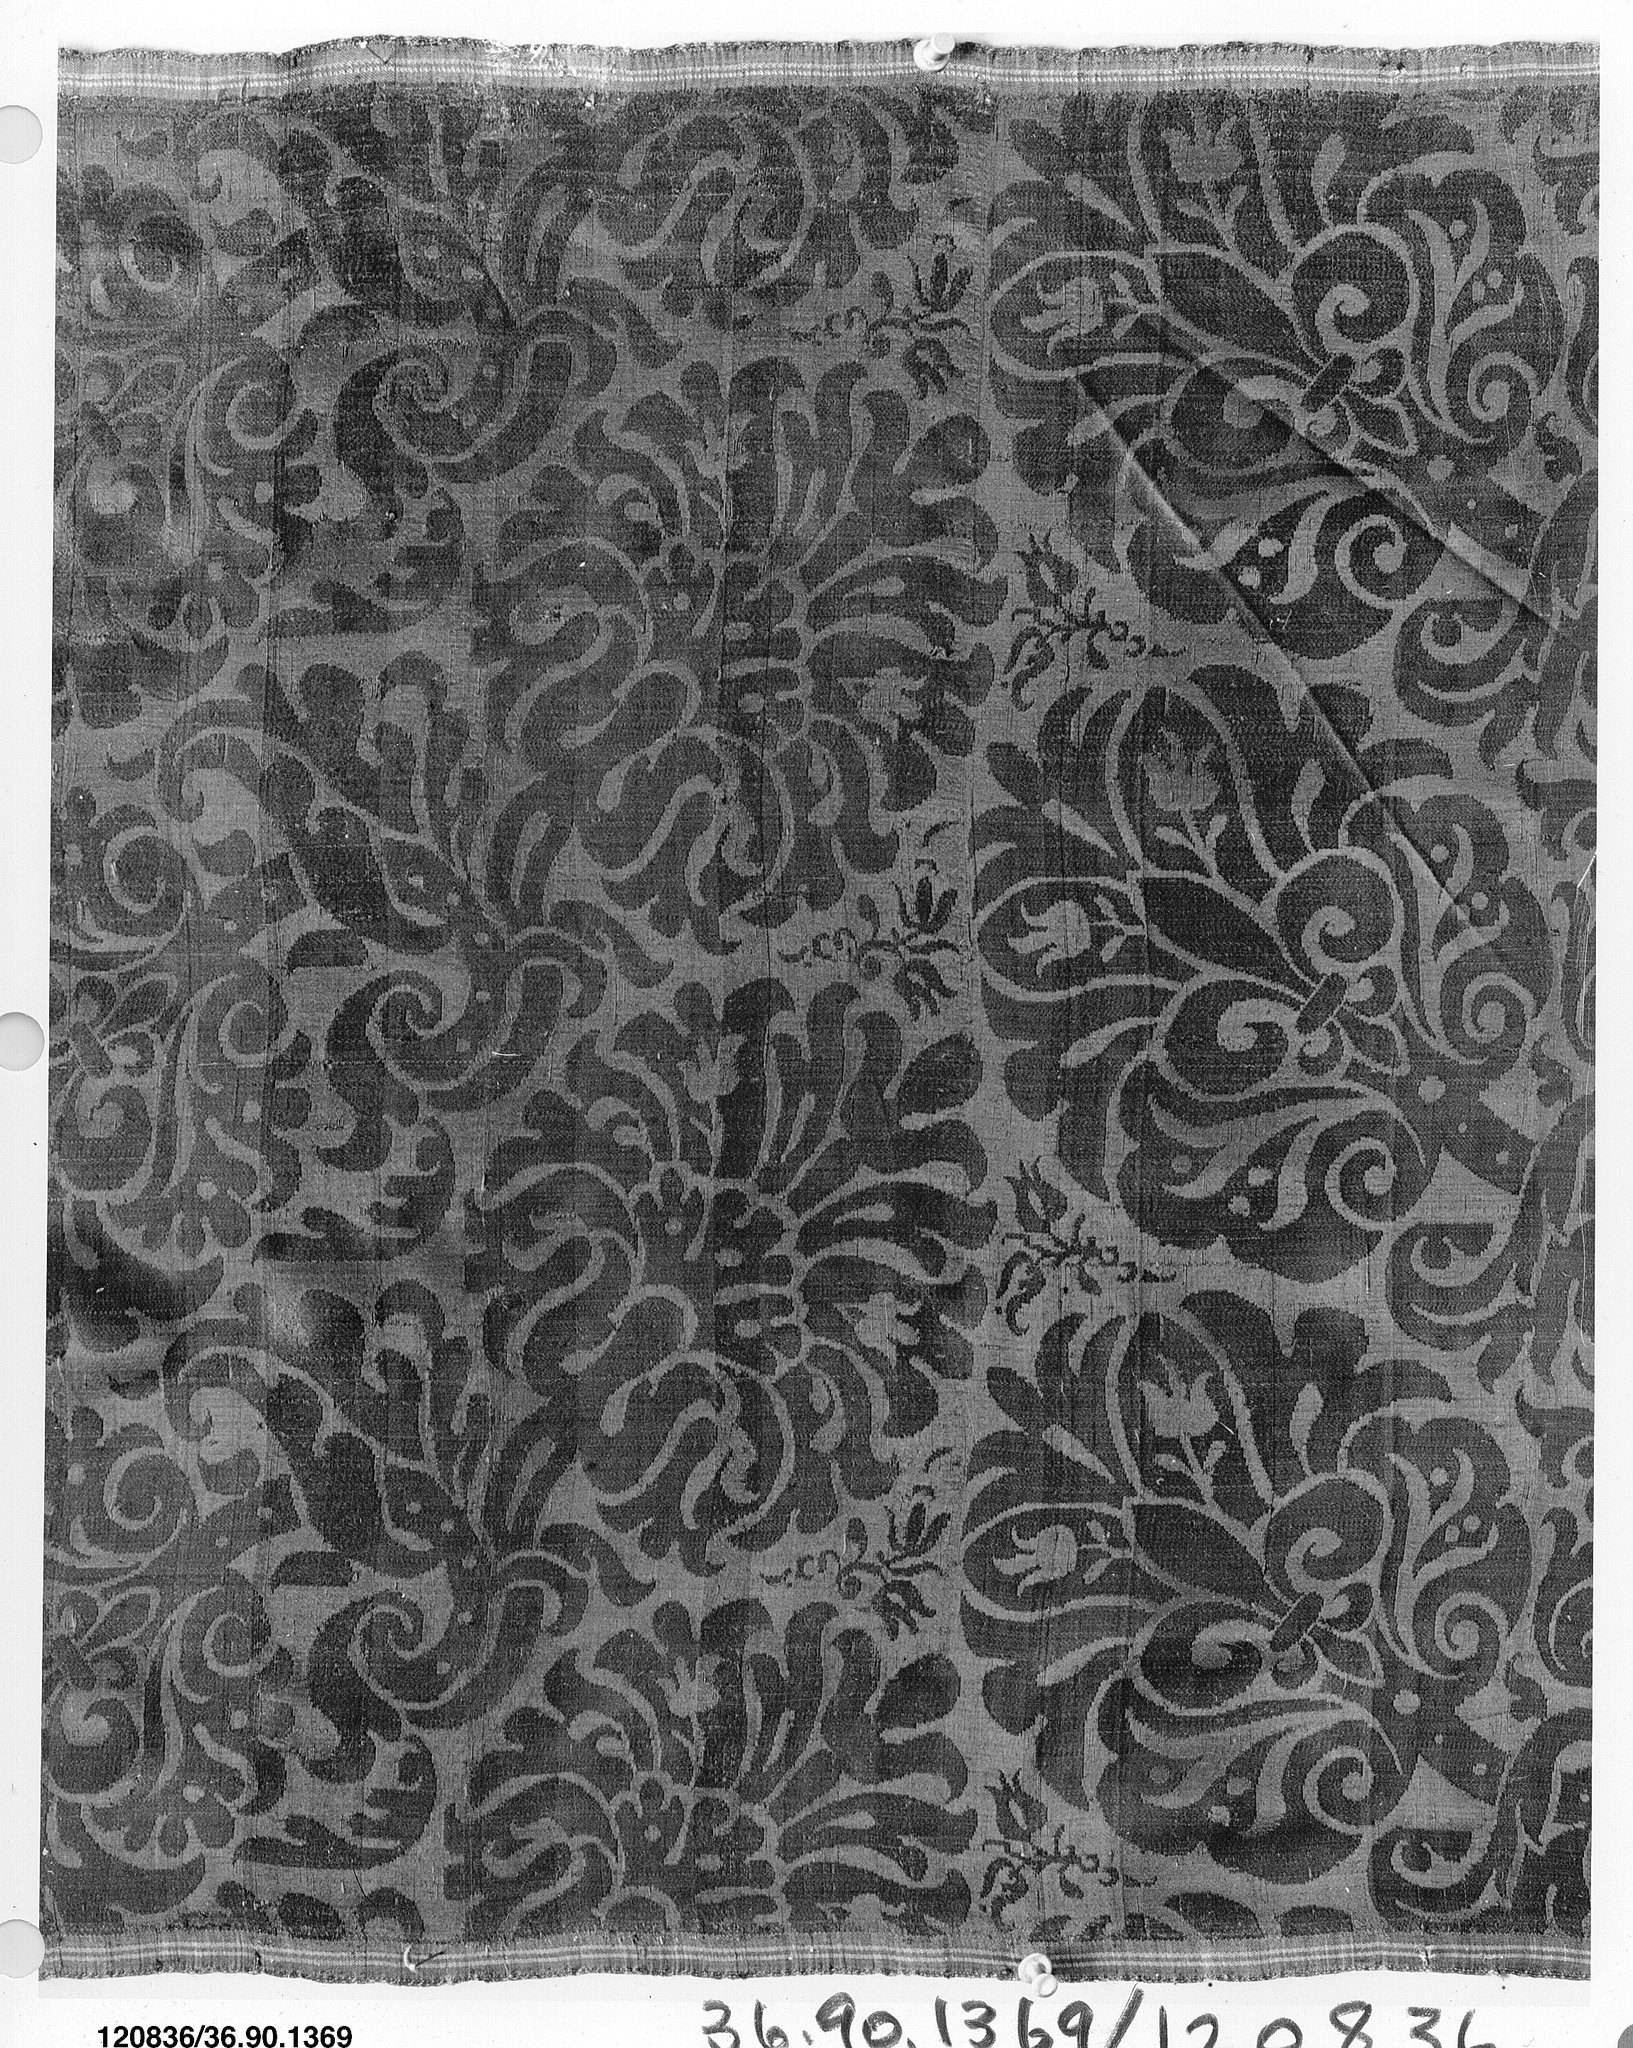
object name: piece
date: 1640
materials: silk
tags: flowers